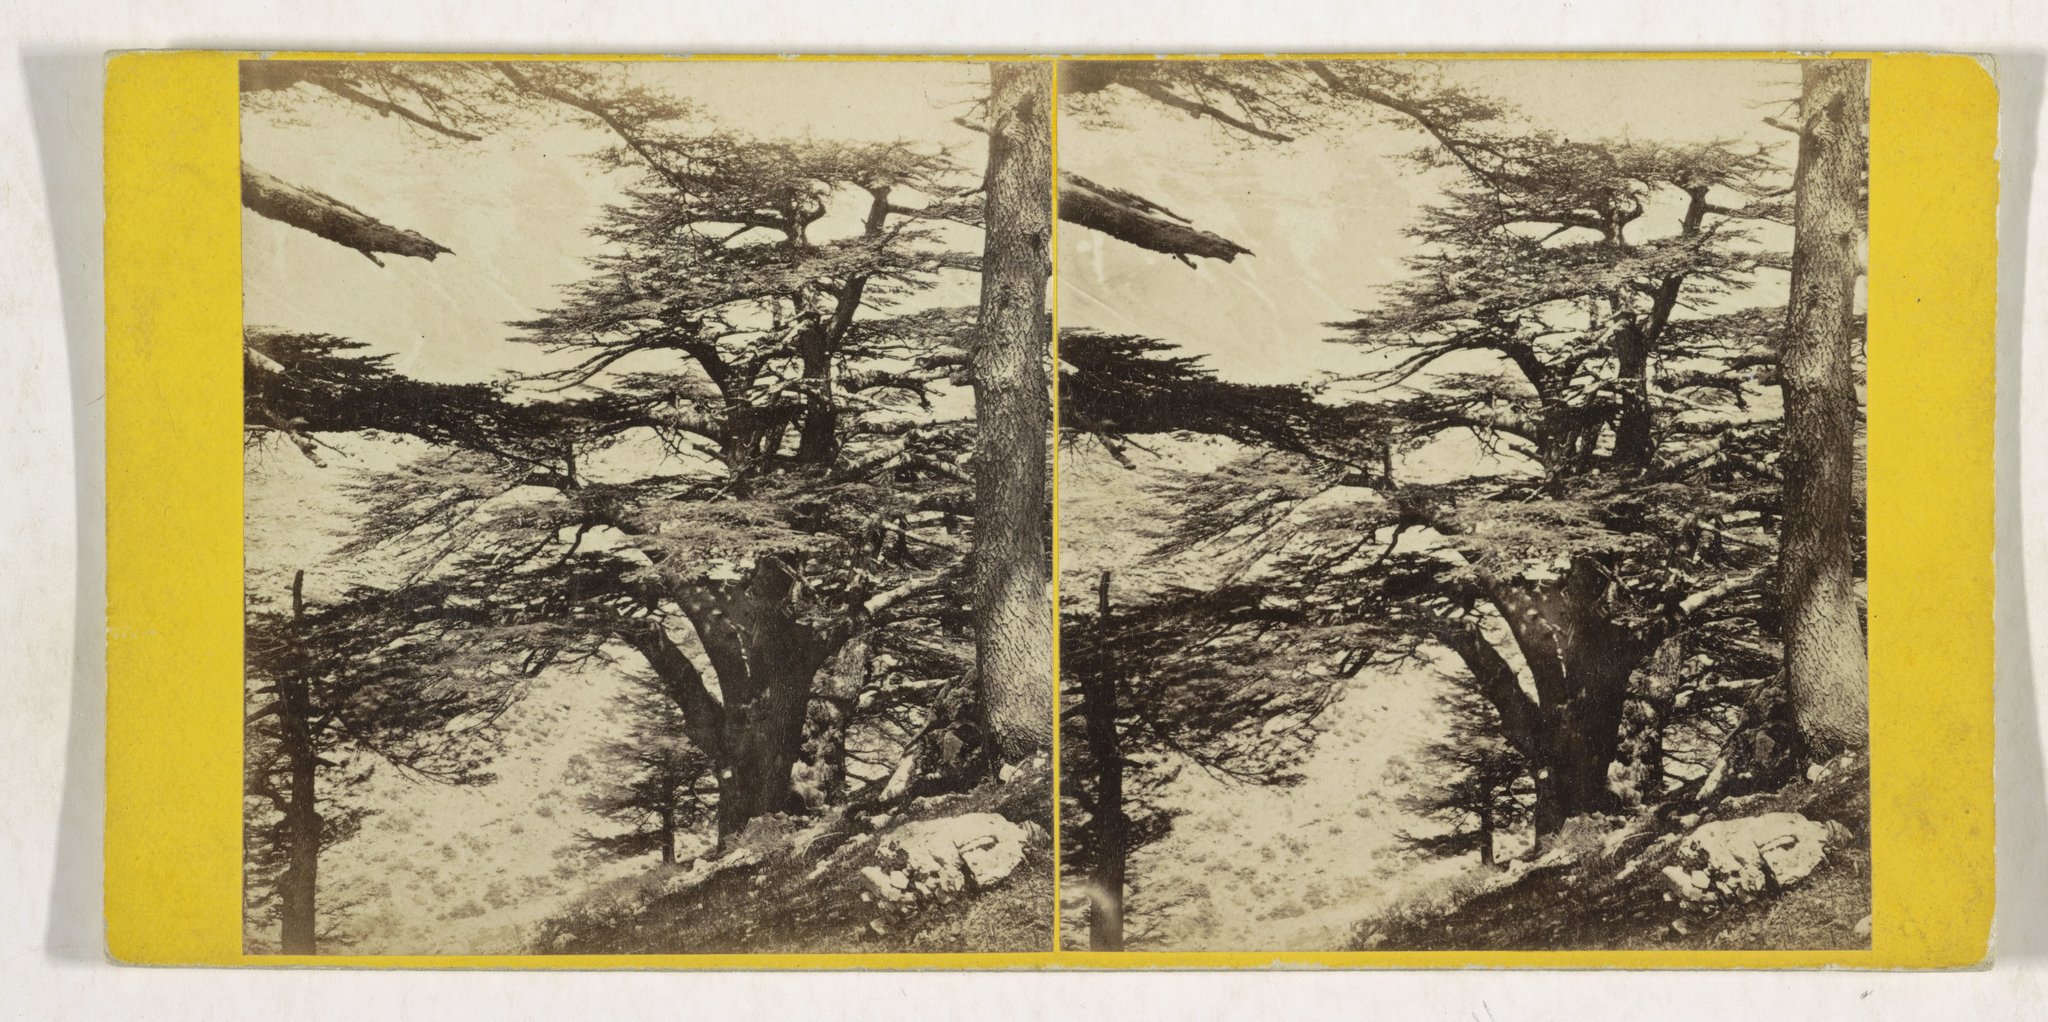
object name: stereograph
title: Good's Eastern Series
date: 1860-1880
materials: cardboard, paper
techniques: albumen print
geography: lebanon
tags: trees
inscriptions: number: ‘No. 347.’